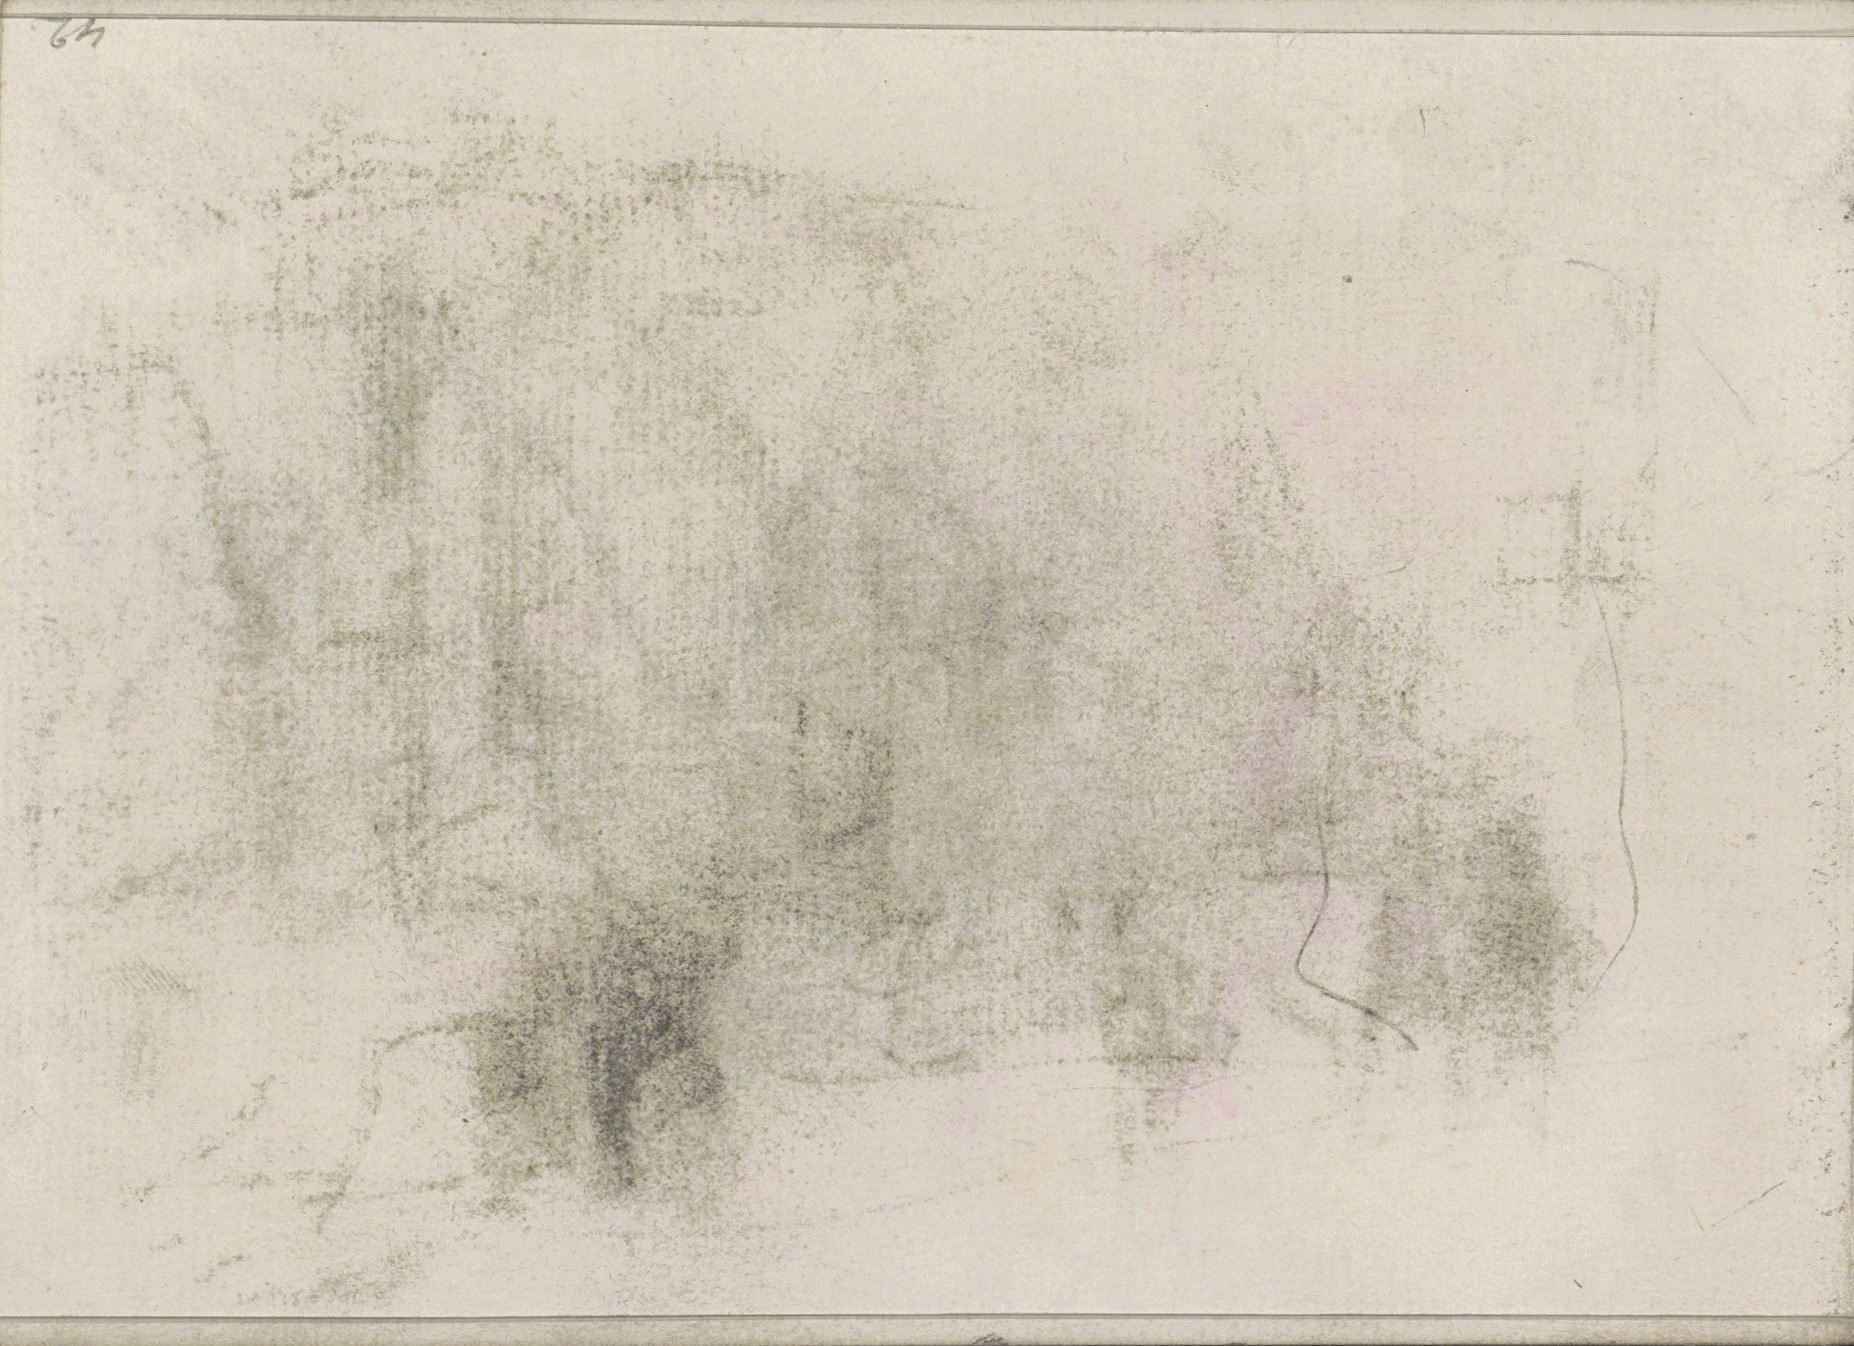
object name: sketchbook leaf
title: Abklatsch van de krijttekening op blad 12 recto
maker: isaac israels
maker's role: draughtsman, painter, print maker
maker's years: 1865-1934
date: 1875-1934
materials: paper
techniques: printmaking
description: Blad 11 verso uit schetsboek LVI met 26 bladen.